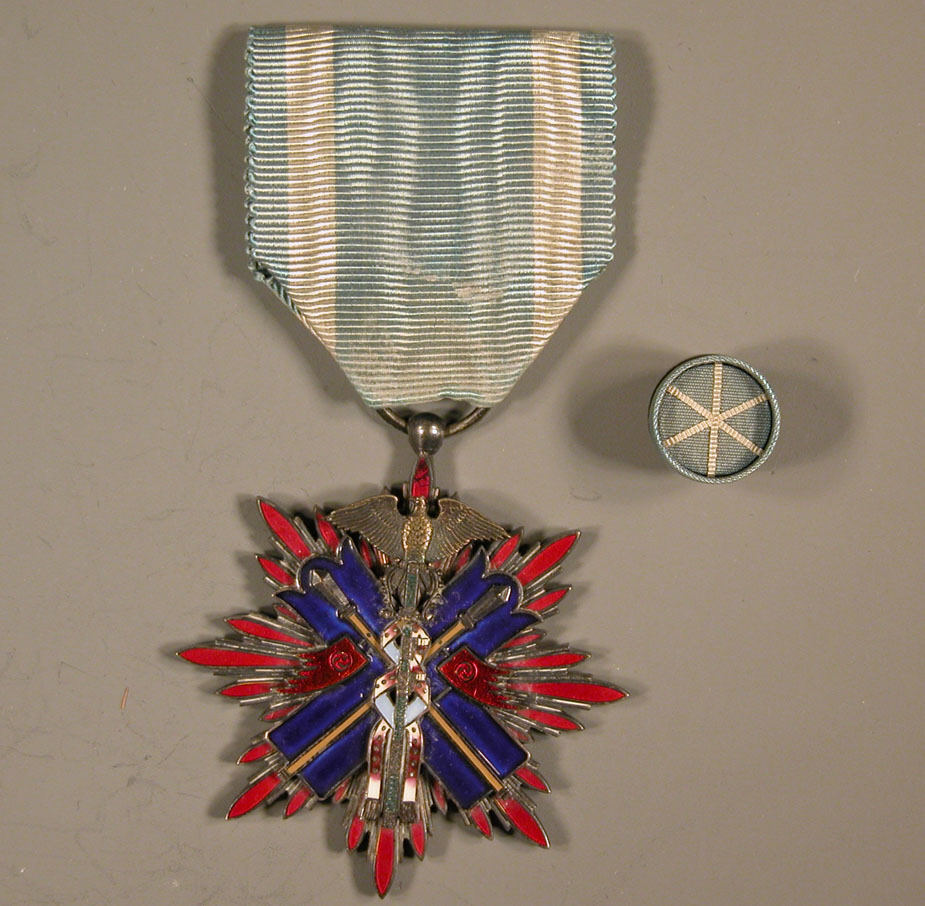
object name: medal and button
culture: japanese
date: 1867-1900